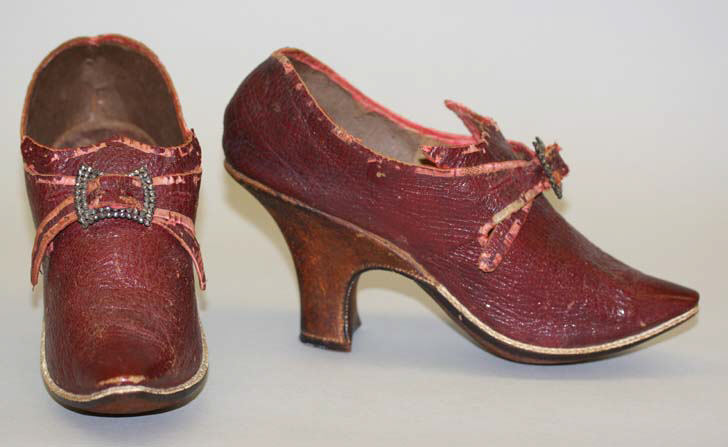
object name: shoe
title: Shoes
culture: french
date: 1701-1800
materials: leather